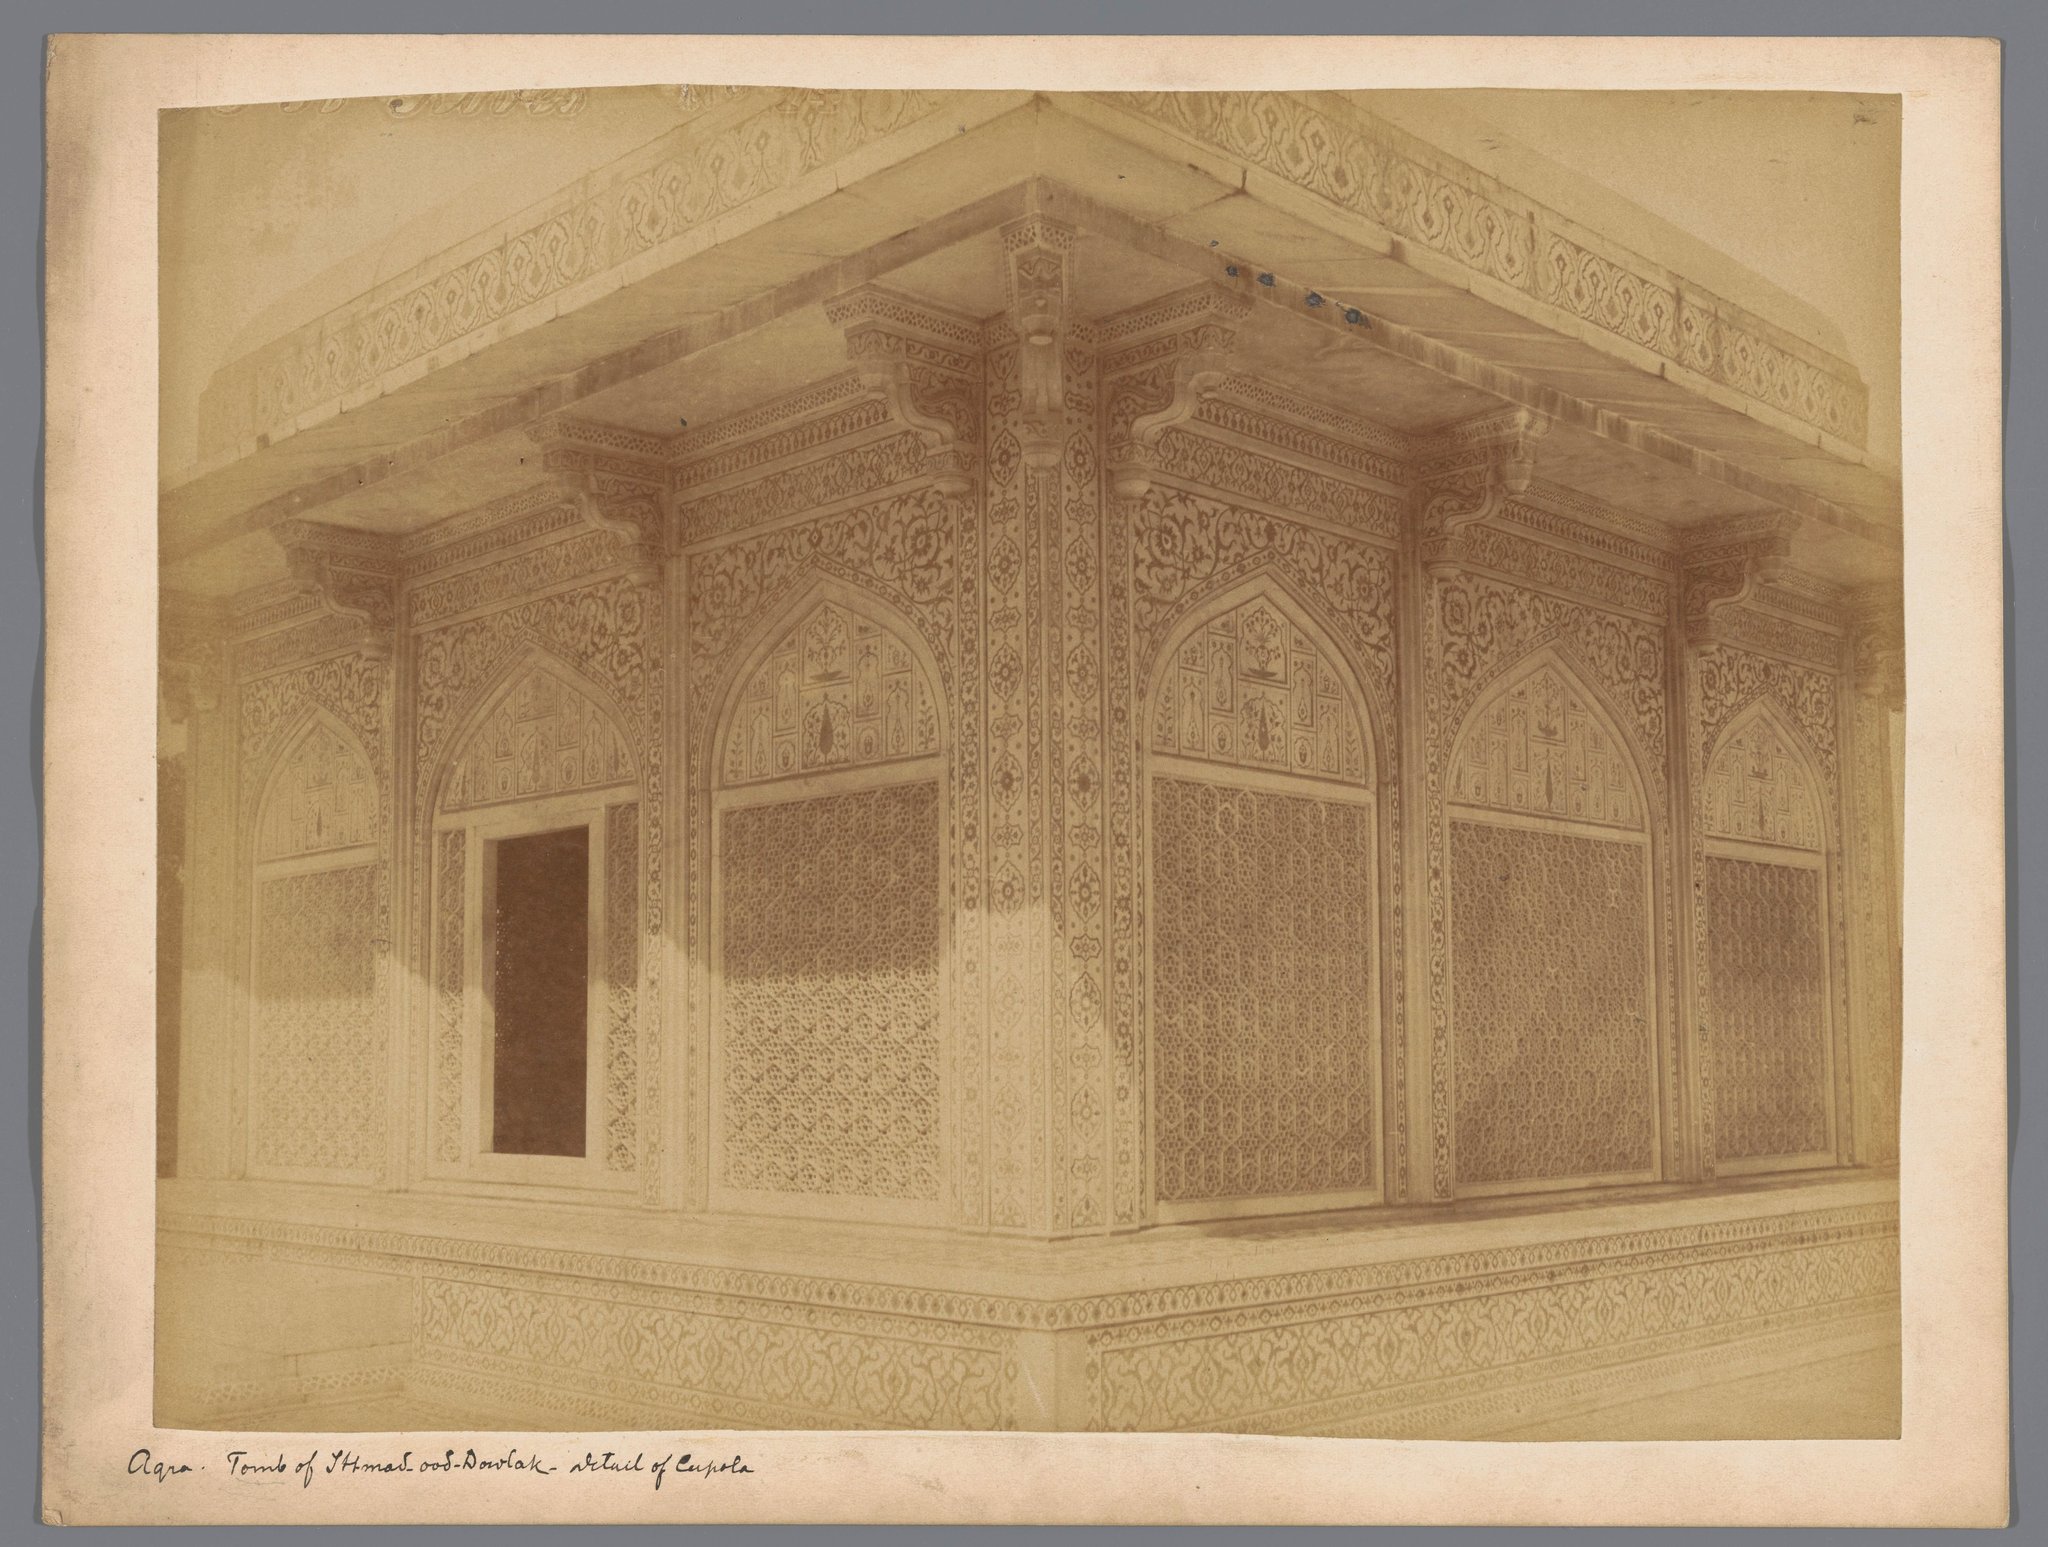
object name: photograph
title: Exterior of the cupola of Itimad-ud-Daulah at Agra, Uttar Pradesh, India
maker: Anonymous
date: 1865-1890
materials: cardboard, paper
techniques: albumen print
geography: agra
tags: mausoleum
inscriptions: watermark: ‘[B]FK Rives No. 74’, number: ‘26’, title: ‘Agra. Tomb of Itimad-ood-Daulak.’